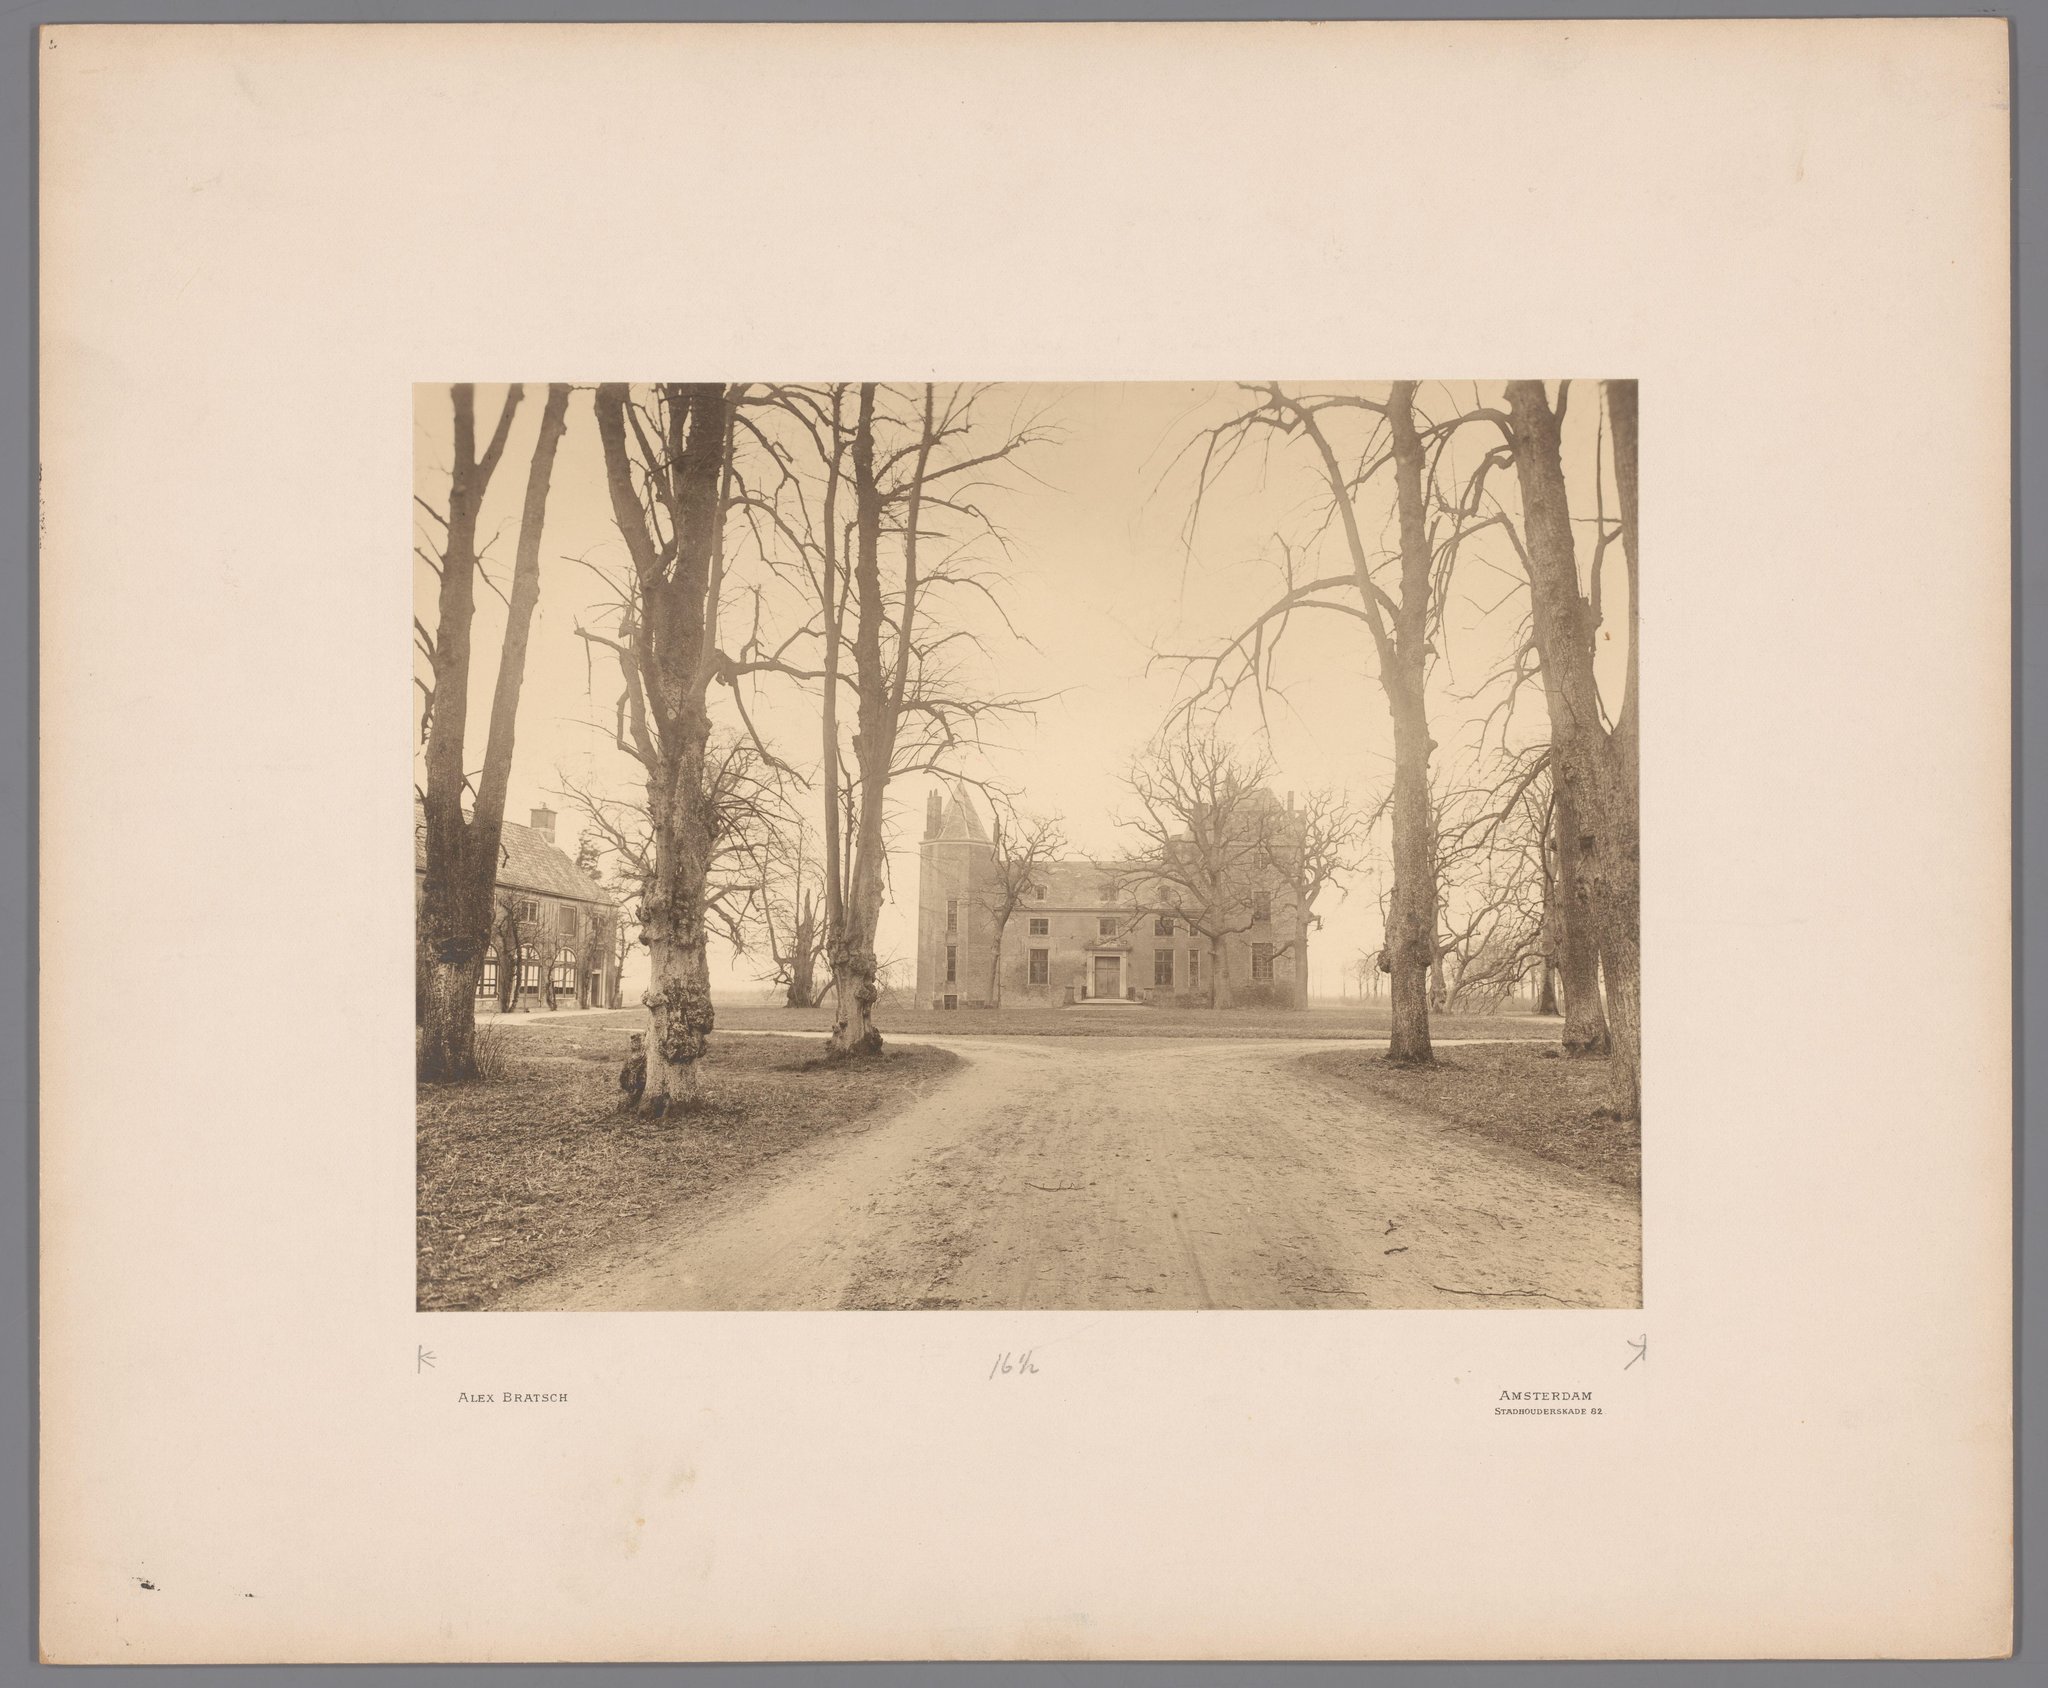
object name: photograph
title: Gezicht op Slot Assumburg bij Heemskerk met oprijlaan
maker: alex bratsch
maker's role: fotograaf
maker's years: 1869-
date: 1910-1930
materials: cardboard, photographic support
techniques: gelatin silver print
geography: heemskerk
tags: castle, garden approach, garden drive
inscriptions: address: ‘Amsterdam/ Stadhouderskade 82’, annotation: ‘16 1/2’, number: ‘118’, annotation: ‘Assumburg Heemskerk NH/ Assendelft/ No 4’